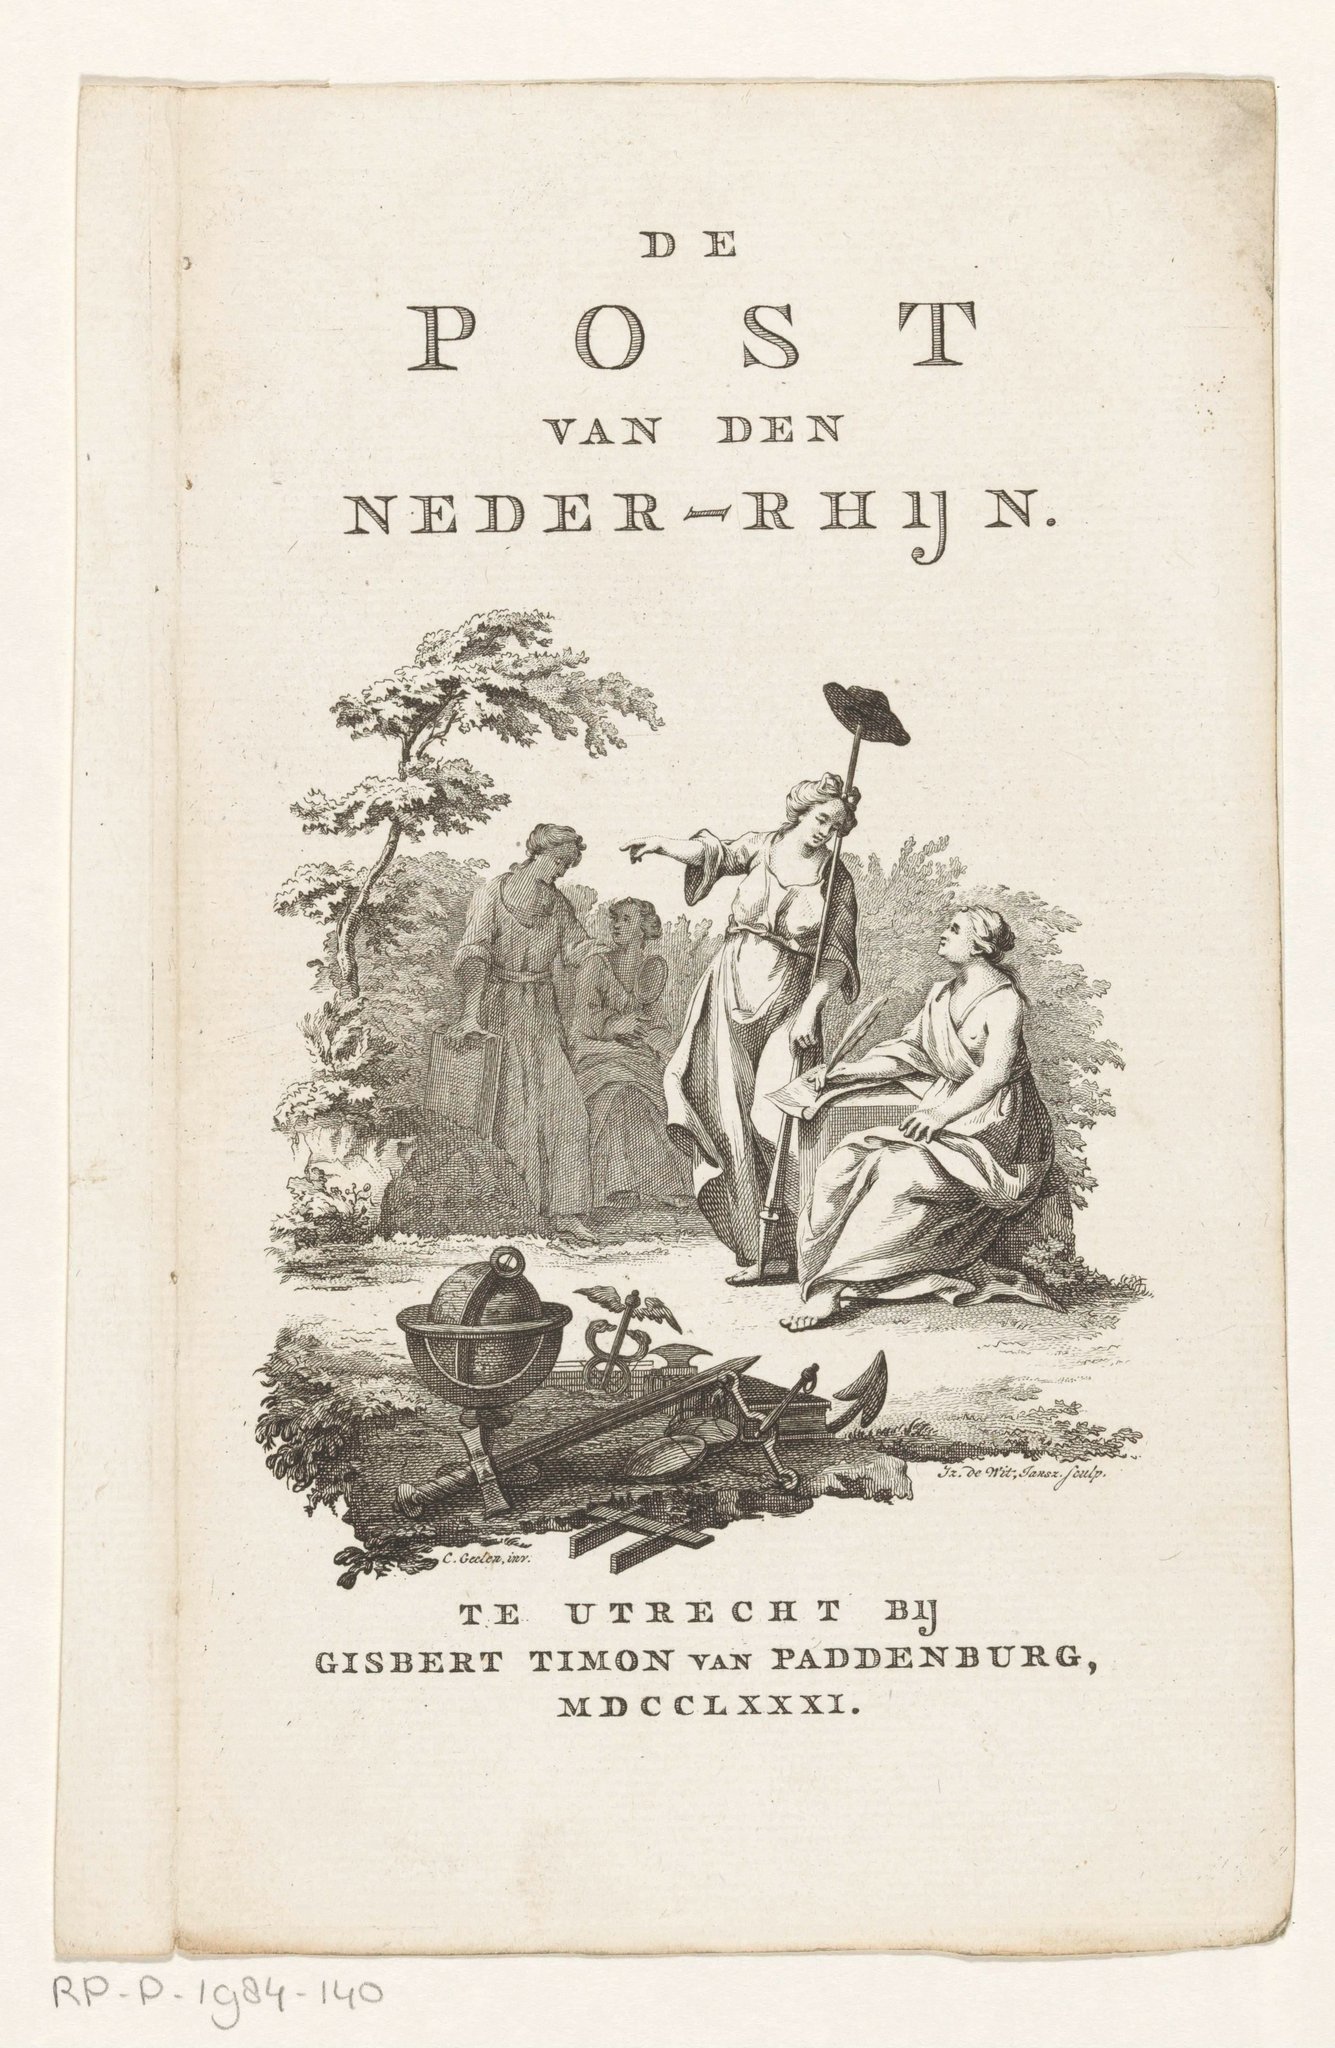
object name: print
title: Titelpagina voor: S.n., De Post van den Neder-Rhijn, 1781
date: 1781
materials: paper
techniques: engraving, etching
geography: utrecht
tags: 'politica' (ripa), freedom, liberty; 'libertà' (ripa) (+ abstract concept represented by female figure)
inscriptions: collector's mark: Lugt 2760, collector's mark: Lugt 2228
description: Staatkunde, schrijvend bij een steen, wordt door de Vrijheid gewezen wordt op de personificaties van Waarheid en Voorzichtigheid.